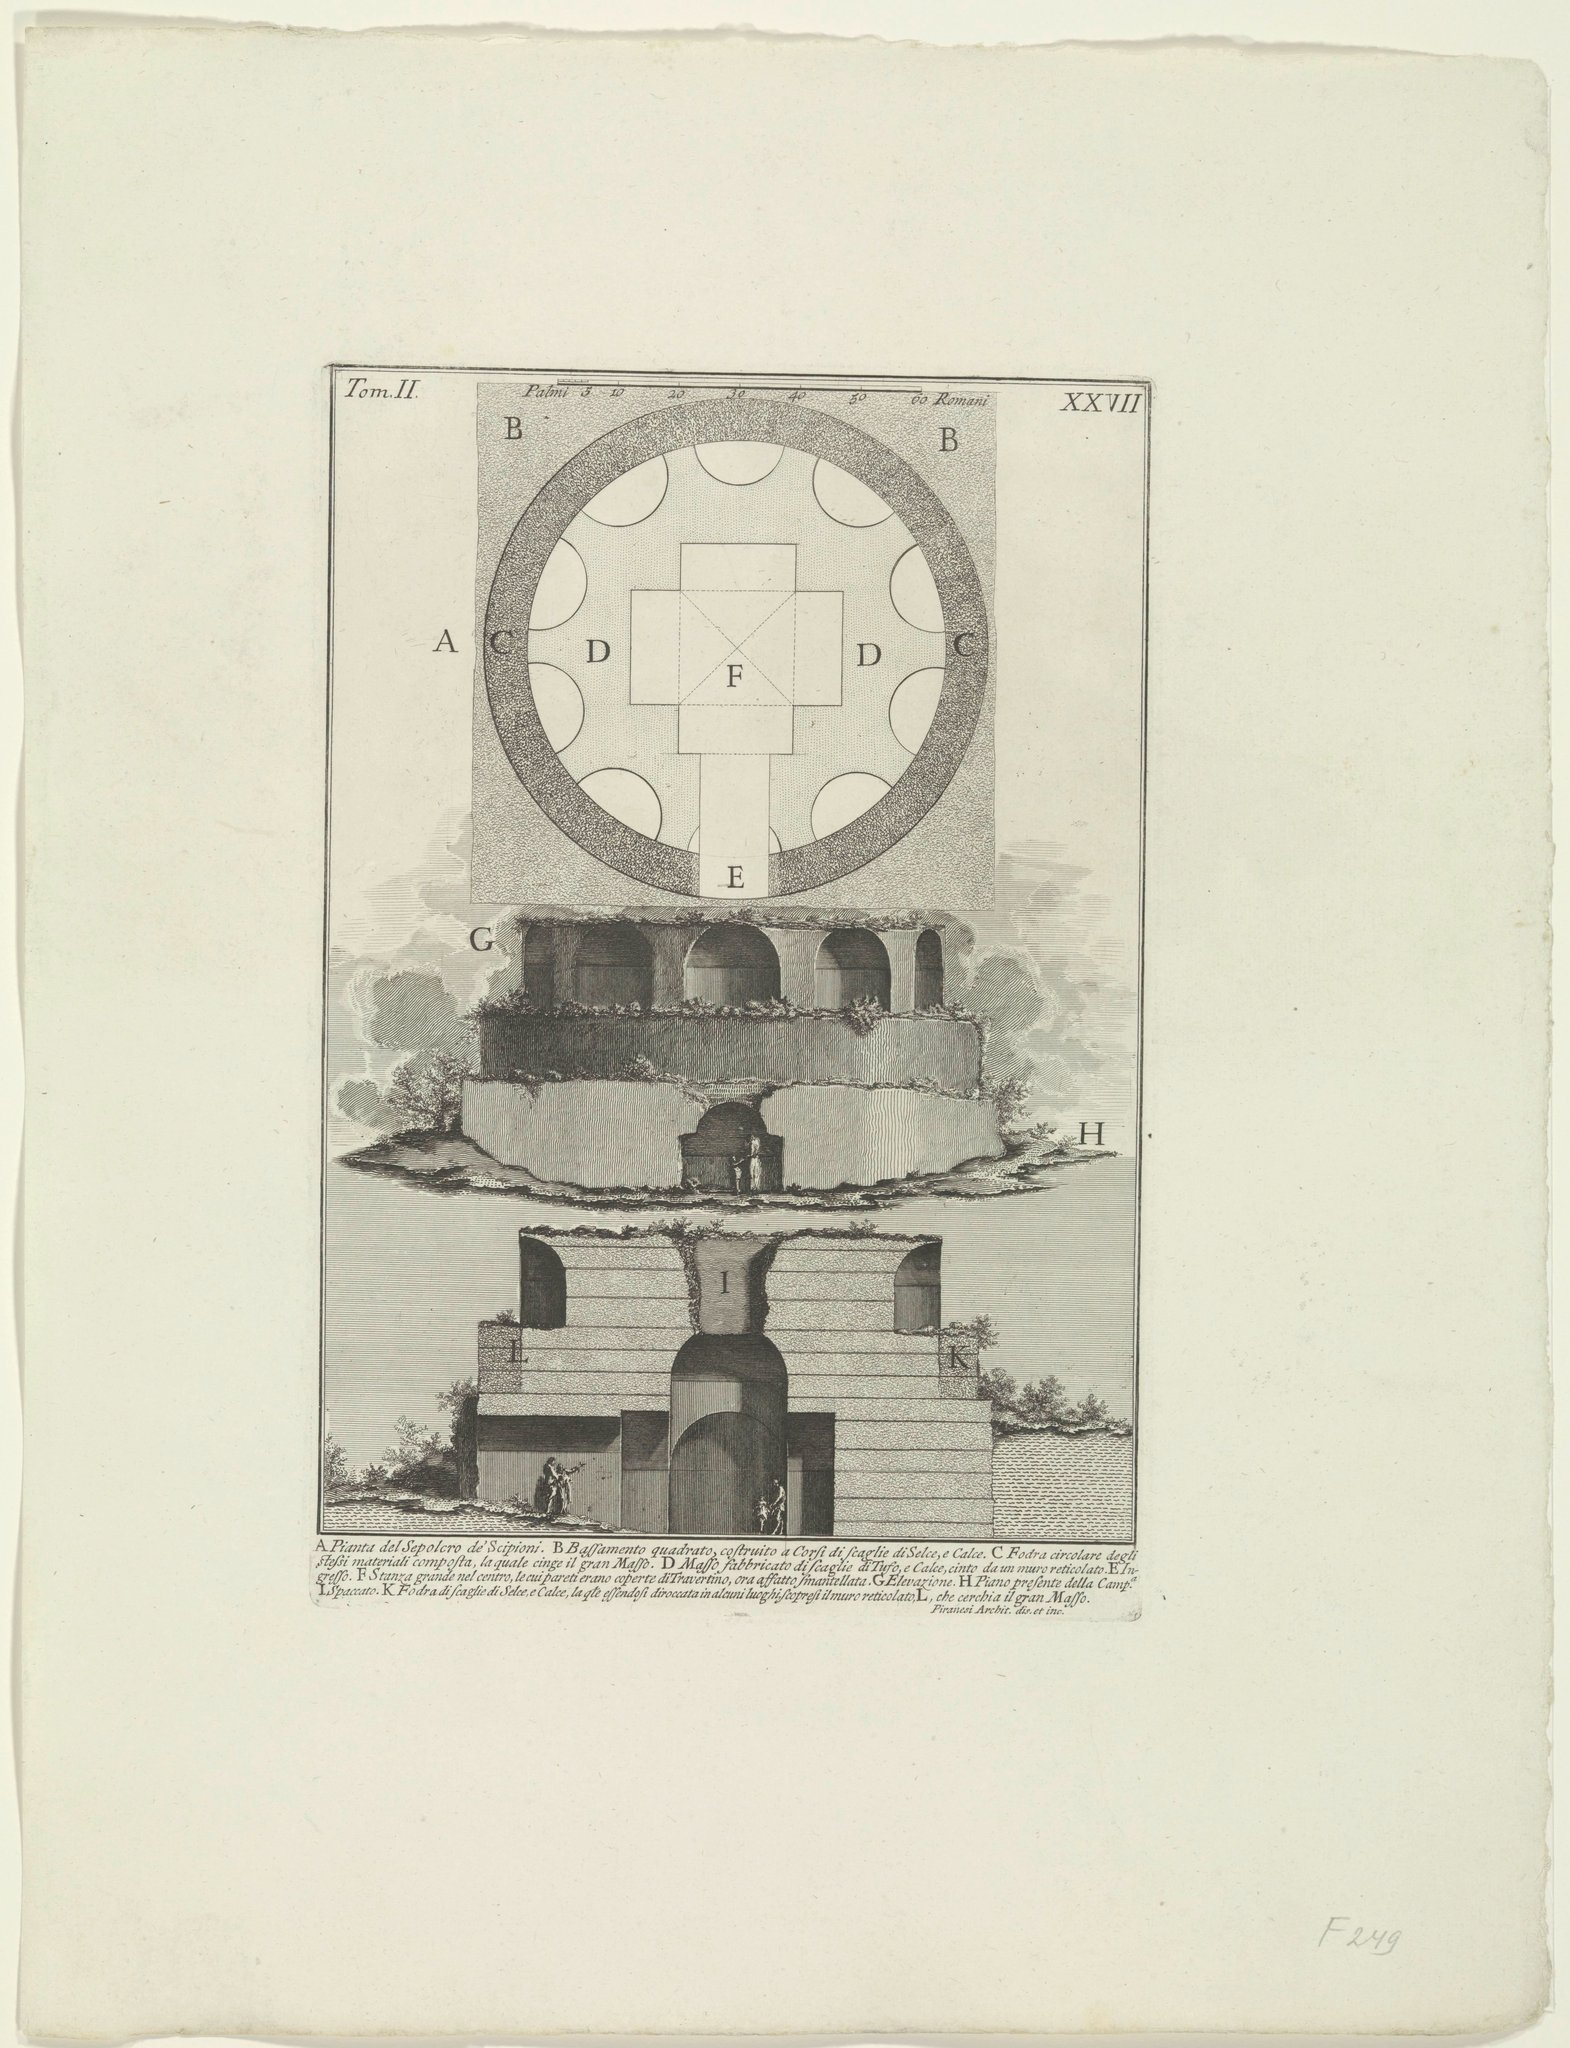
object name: print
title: Graftombe van de Scipio familie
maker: giovanni battista piranesi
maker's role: designer, draughtsman, print maker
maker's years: 1720-1778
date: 1756-1757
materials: paper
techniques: etching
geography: rome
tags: ruin of a building ~ architecture, grave, tomb, rome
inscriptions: collector's mark: Lugt 2228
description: Deze prent maakt deel uit van de serie 'Le Antichità Romane'. Piranesi deed meer dan acht jaar voorstudie voor deze 250 platen tellende serie die in vier volumes werd uitgegeven. Hij produceerde de prenten tussen ca. 1756 en 1757. De serie bevat ook prenten door of naar andere prentmakers, onder wie Francesco Bianchini en Girolamo Rossi.